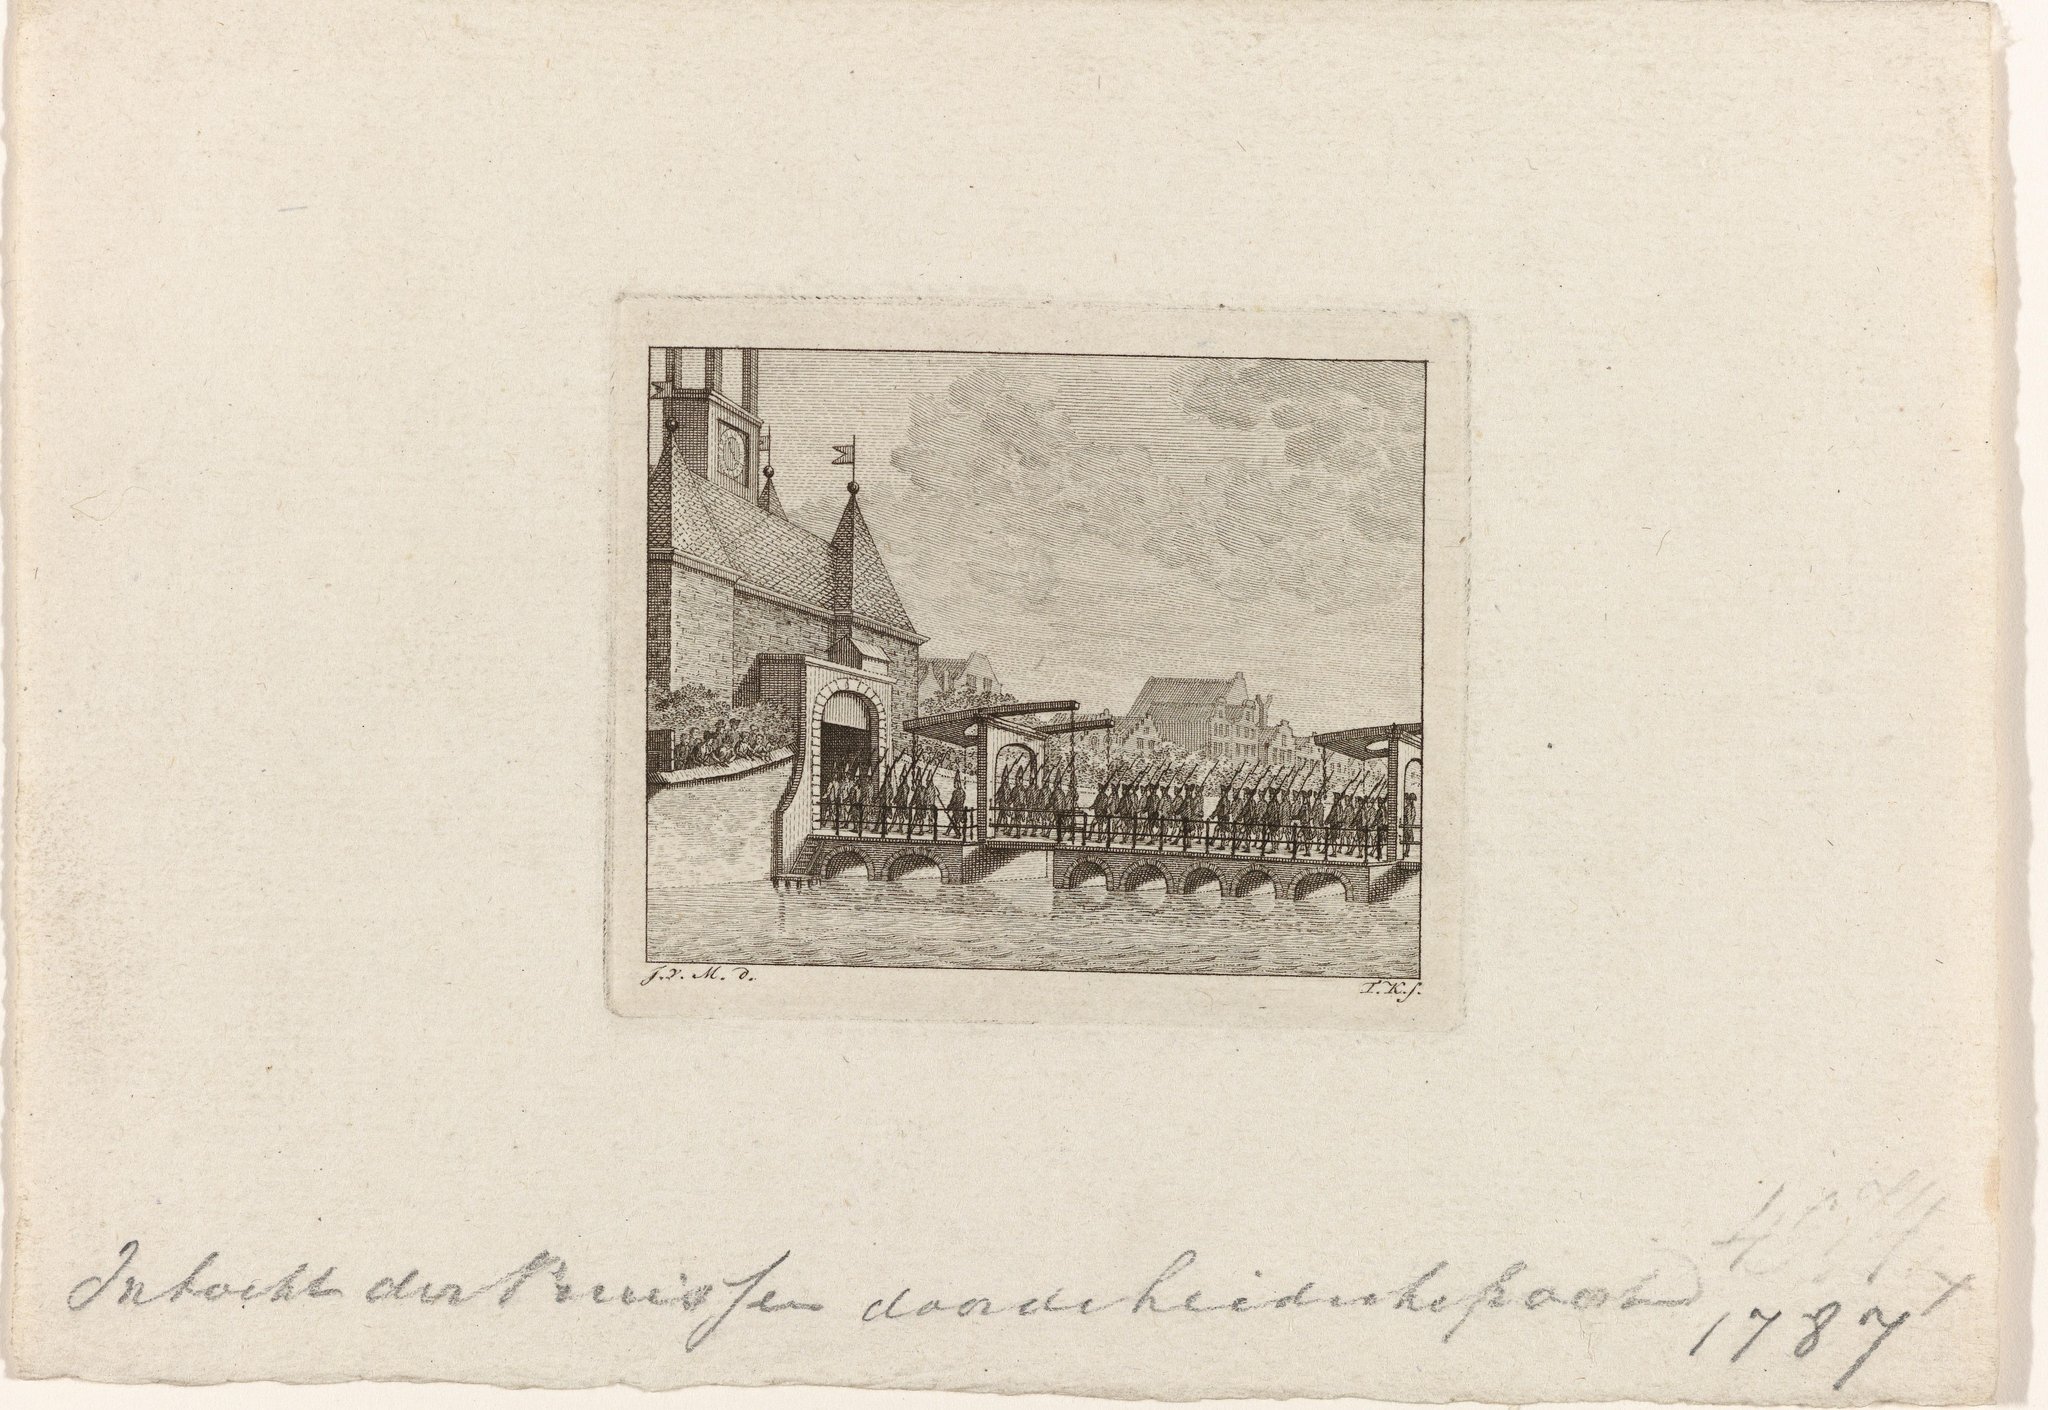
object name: book illustration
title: Pruisen trekken Amsterdam in, 1787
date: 1794-1796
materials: paper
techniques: etching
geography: northern netherlands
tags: leidsepoort, pruisische inval in de republiek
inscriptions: collector's mark: Lugt 2228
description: Gebruikt als illustratie in: Johannes Hazeu, Historie der omwentelingen [1787-1796] in vaderlandsche gesprekken voor kinderen. Amsterdam 1796.